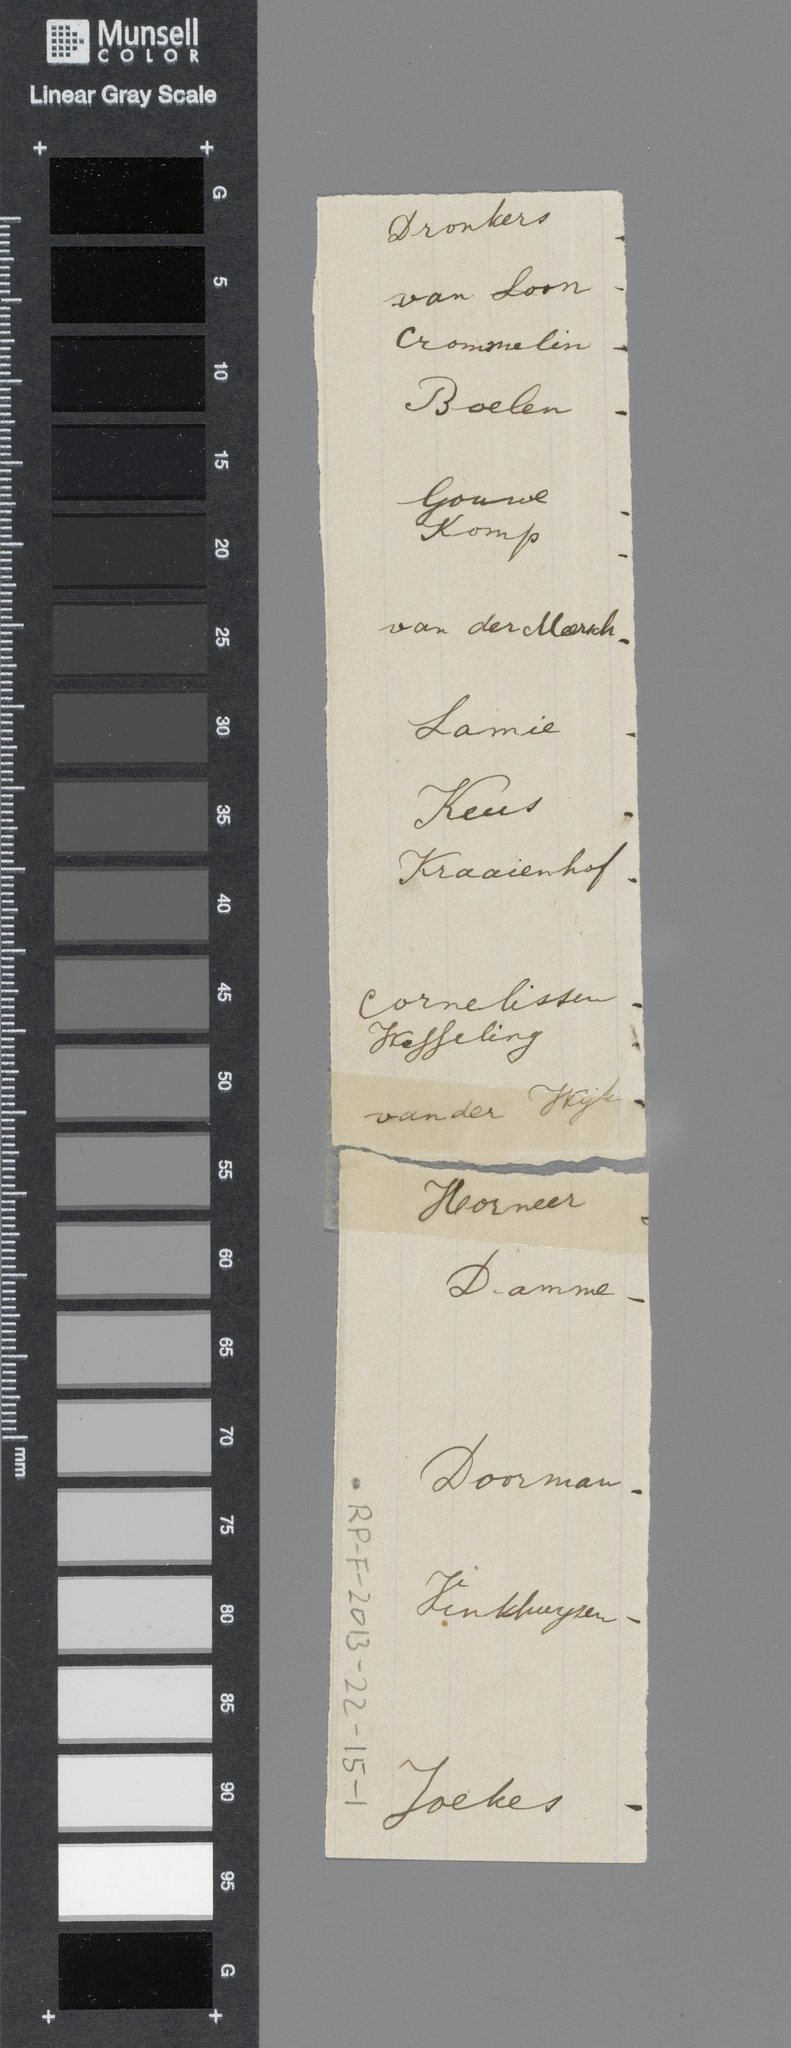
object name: list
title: Namenlijst van het Etat-major aan dek van Z.M. stoomschip 'Zoutman'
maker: Anonymous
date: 1807-1865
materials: paper, plastic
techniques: writing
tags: crew ~ ship, parts of ship's exterior: deck, sailing-ship, sailing-boat (with name), steamship, motorship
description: Los in het fotoalbum aangetroffen gelinieerde strook papier met daarop handgeschreven de namen van het Etat-major aan dek van Z.M. stoomschip 'Zoutman', te weten Dronkers, Van Loon, Crommelin, Boelen, Gouwe, Kamp, Van der Meersch, Lamie, Keus en Kraaienhof, Cornelissen, Heffeling, Van der Wijk, Horneer, Damme, Doorman, Vinkhuyzen, Joekes. De strook papier is gescheurd en gerepareerd met plakband. Onderdeel van Fotoalbum van Robert Daniel Crommelin (1841-1907).